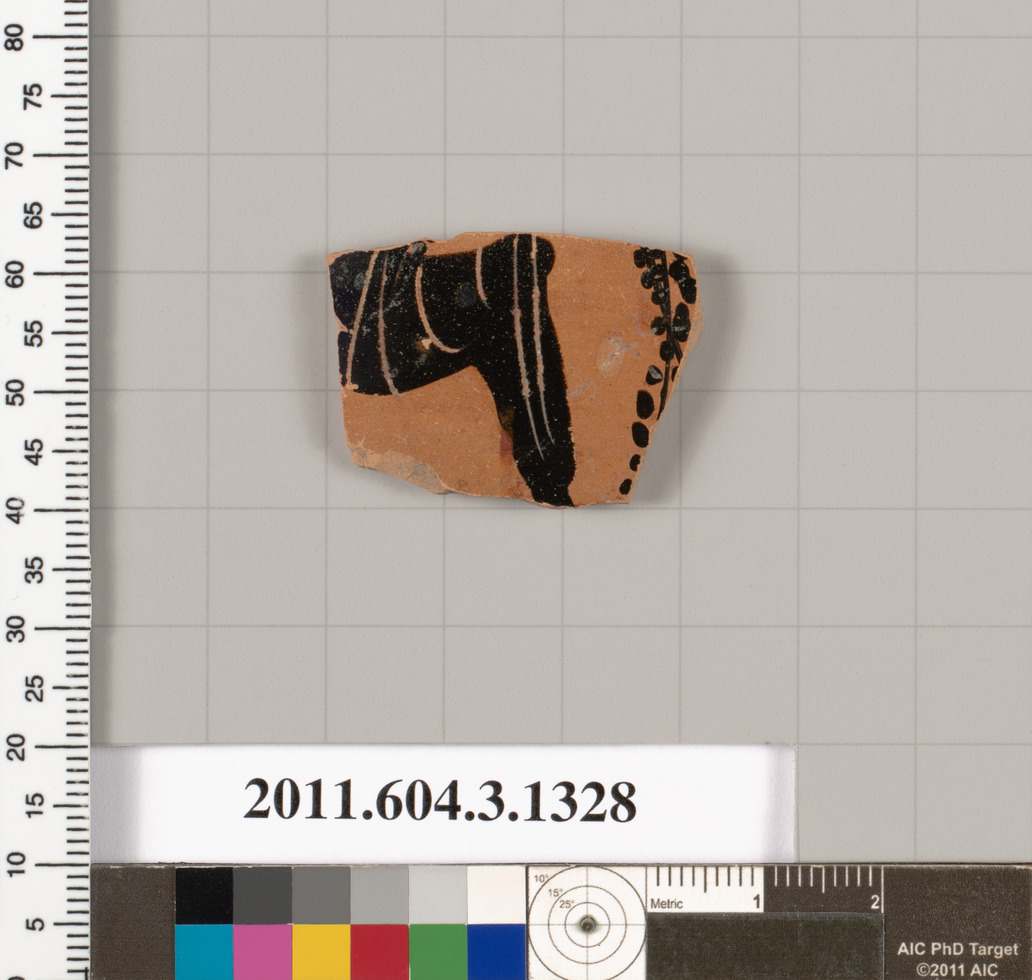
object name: skyphos fragment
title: Terracotta fragment of a skyphos (deep drinking cup)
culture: greek, attic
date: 500-468 BCE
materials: terracotta